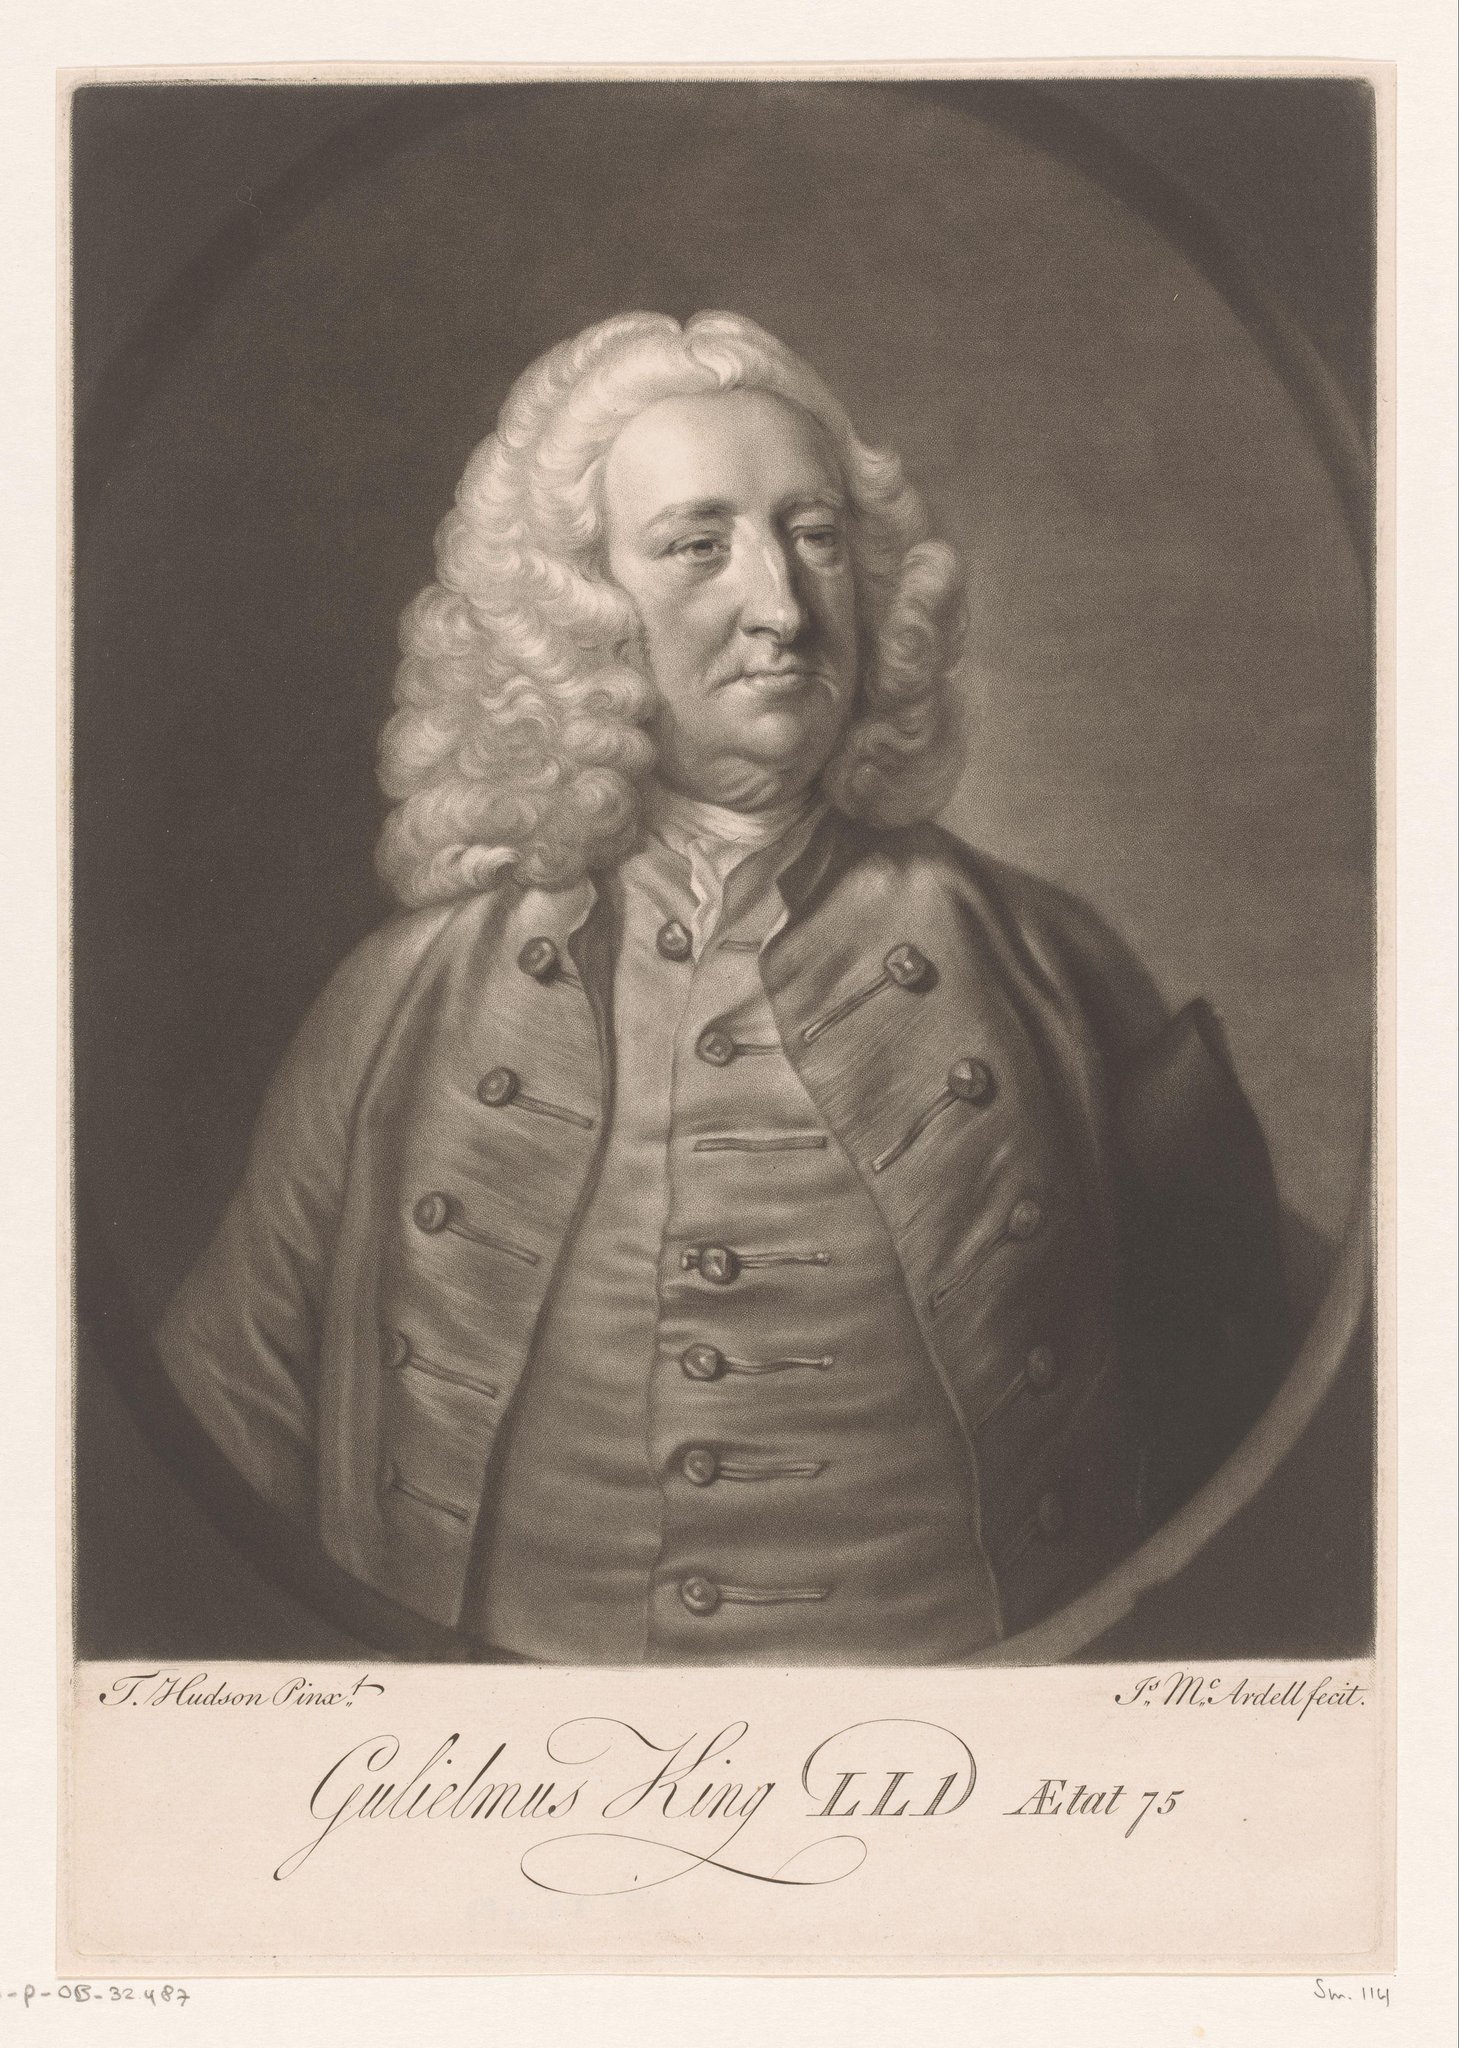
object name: print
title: Portret van William King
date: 1760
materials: paper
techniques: mezzotint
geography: london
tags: historical persons, portrait of a writer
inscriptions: collector's mark: Lugt 240